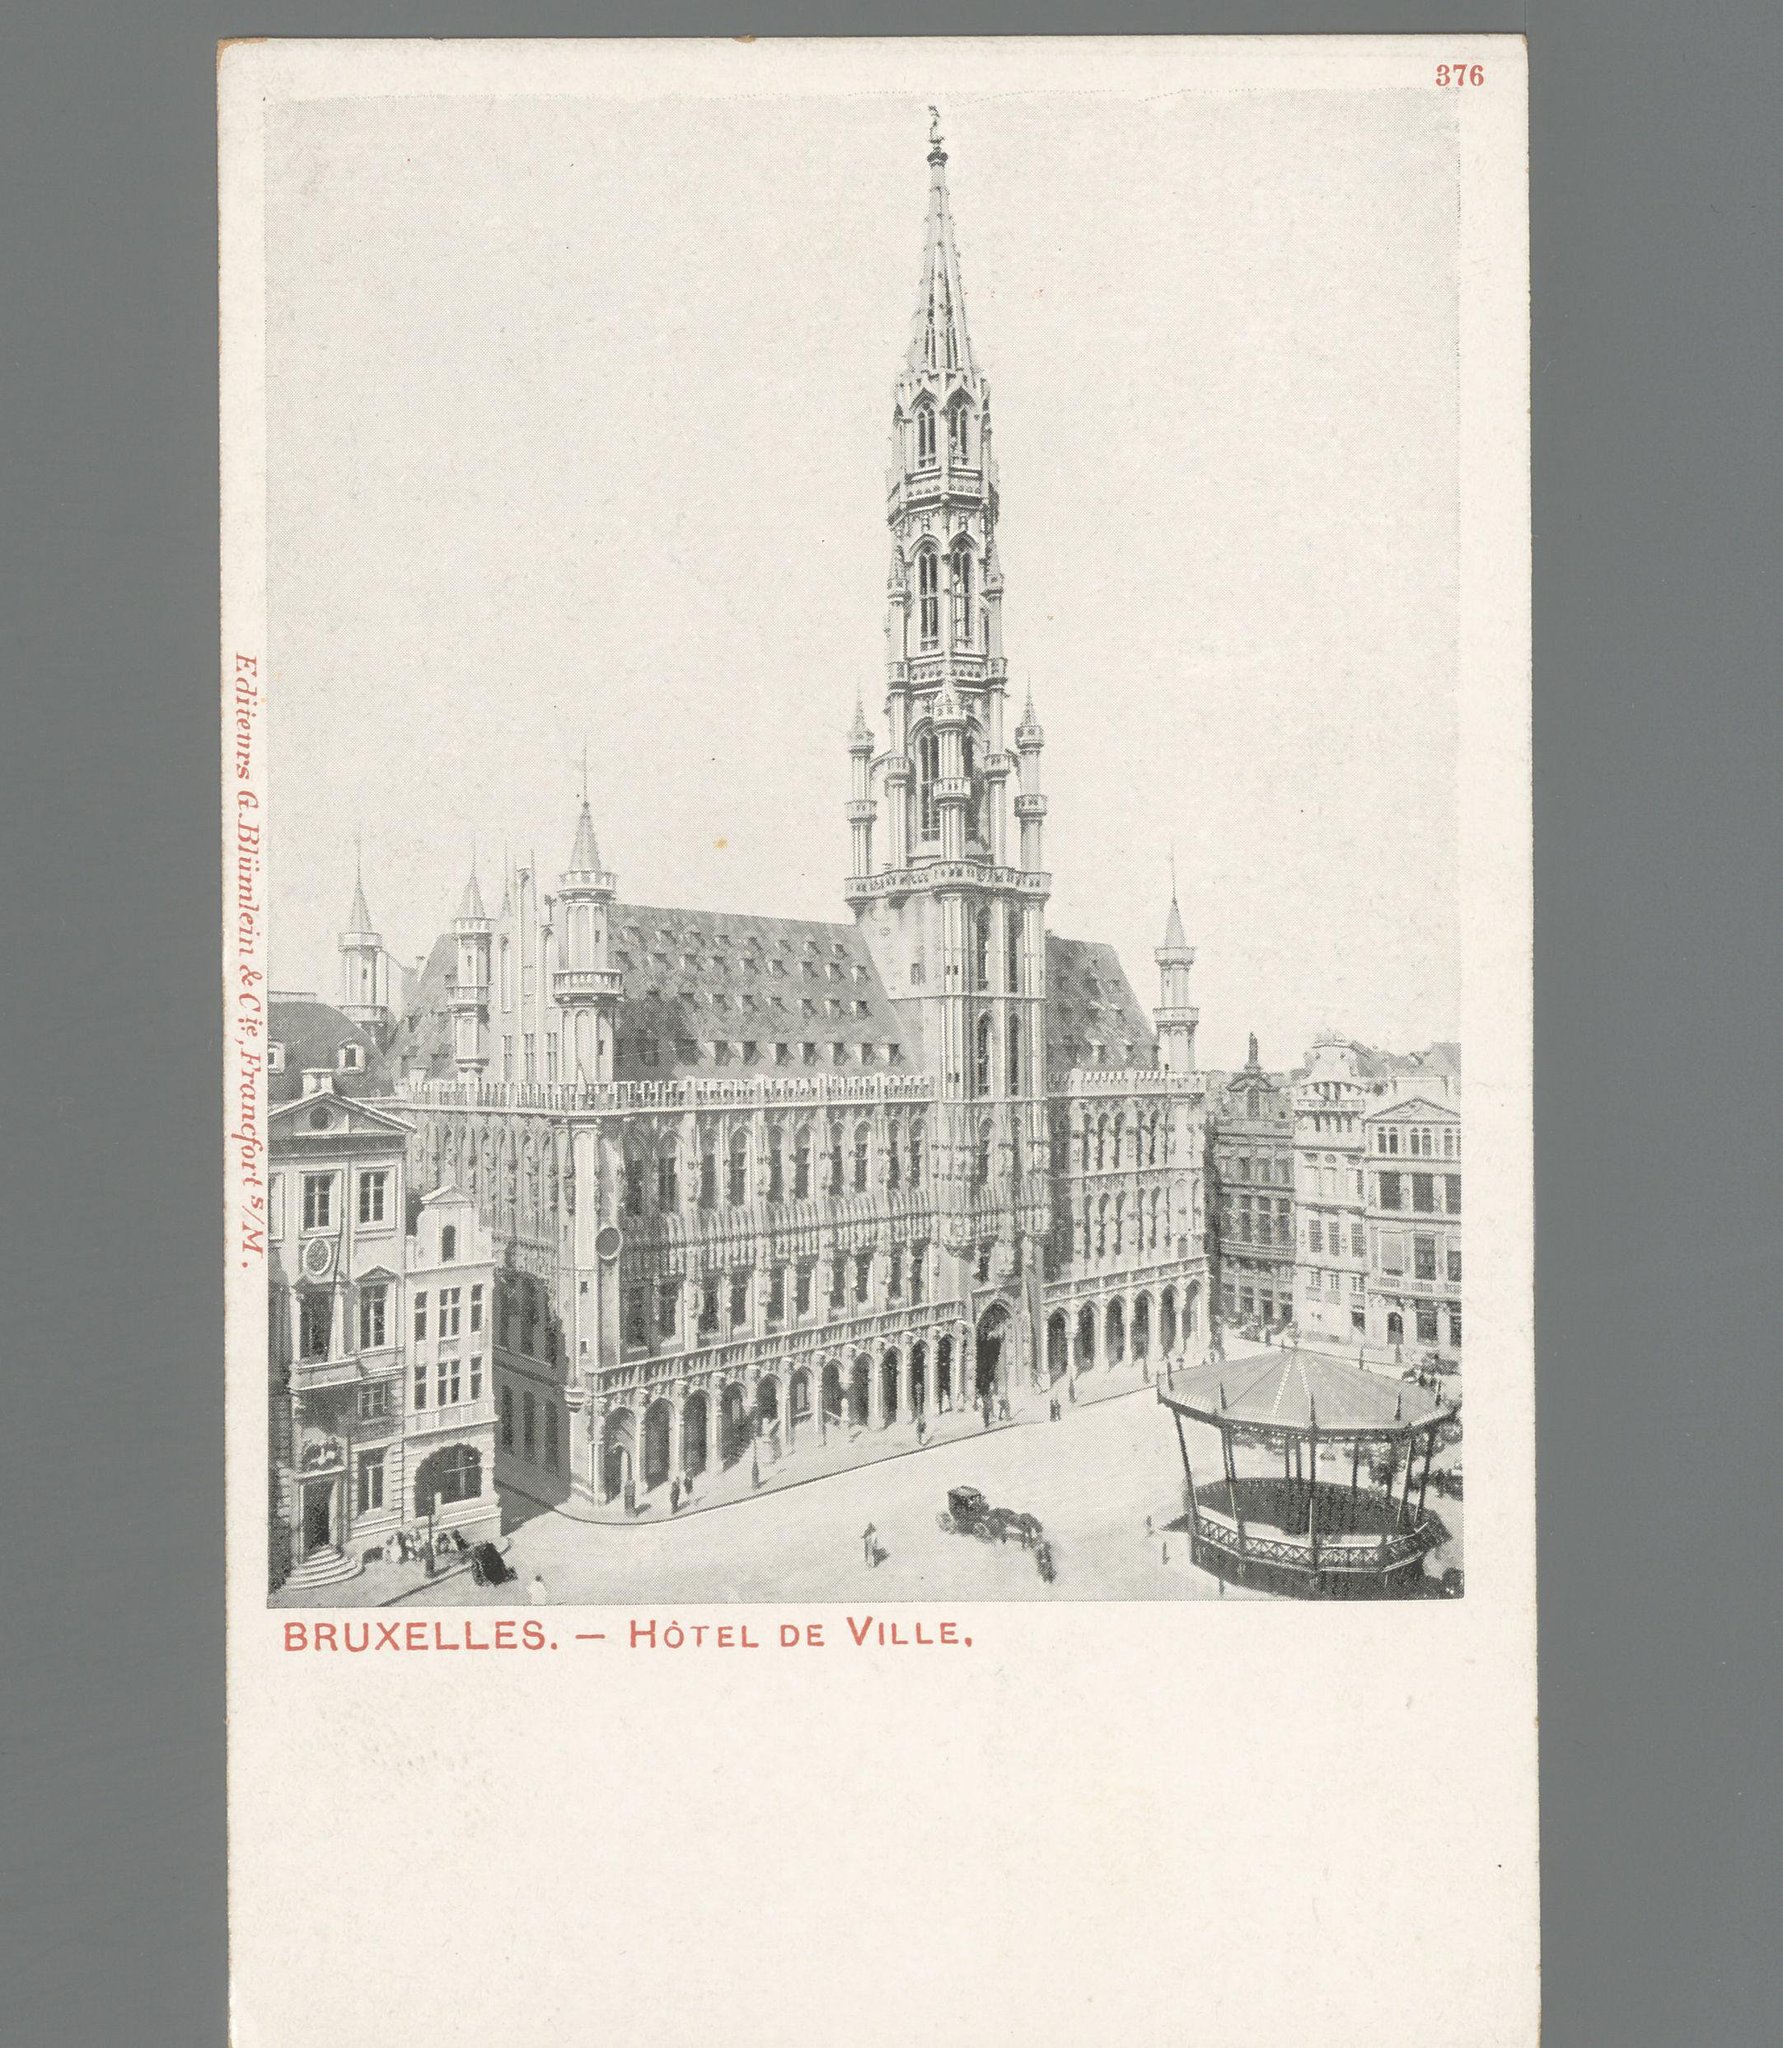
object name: photomechanical print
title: Bruxelles. Hôtel de Ville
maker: Anonymous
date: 1894-1906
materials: cardboard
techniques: autotype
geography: brussels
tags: square, place, circus, etc., townhall